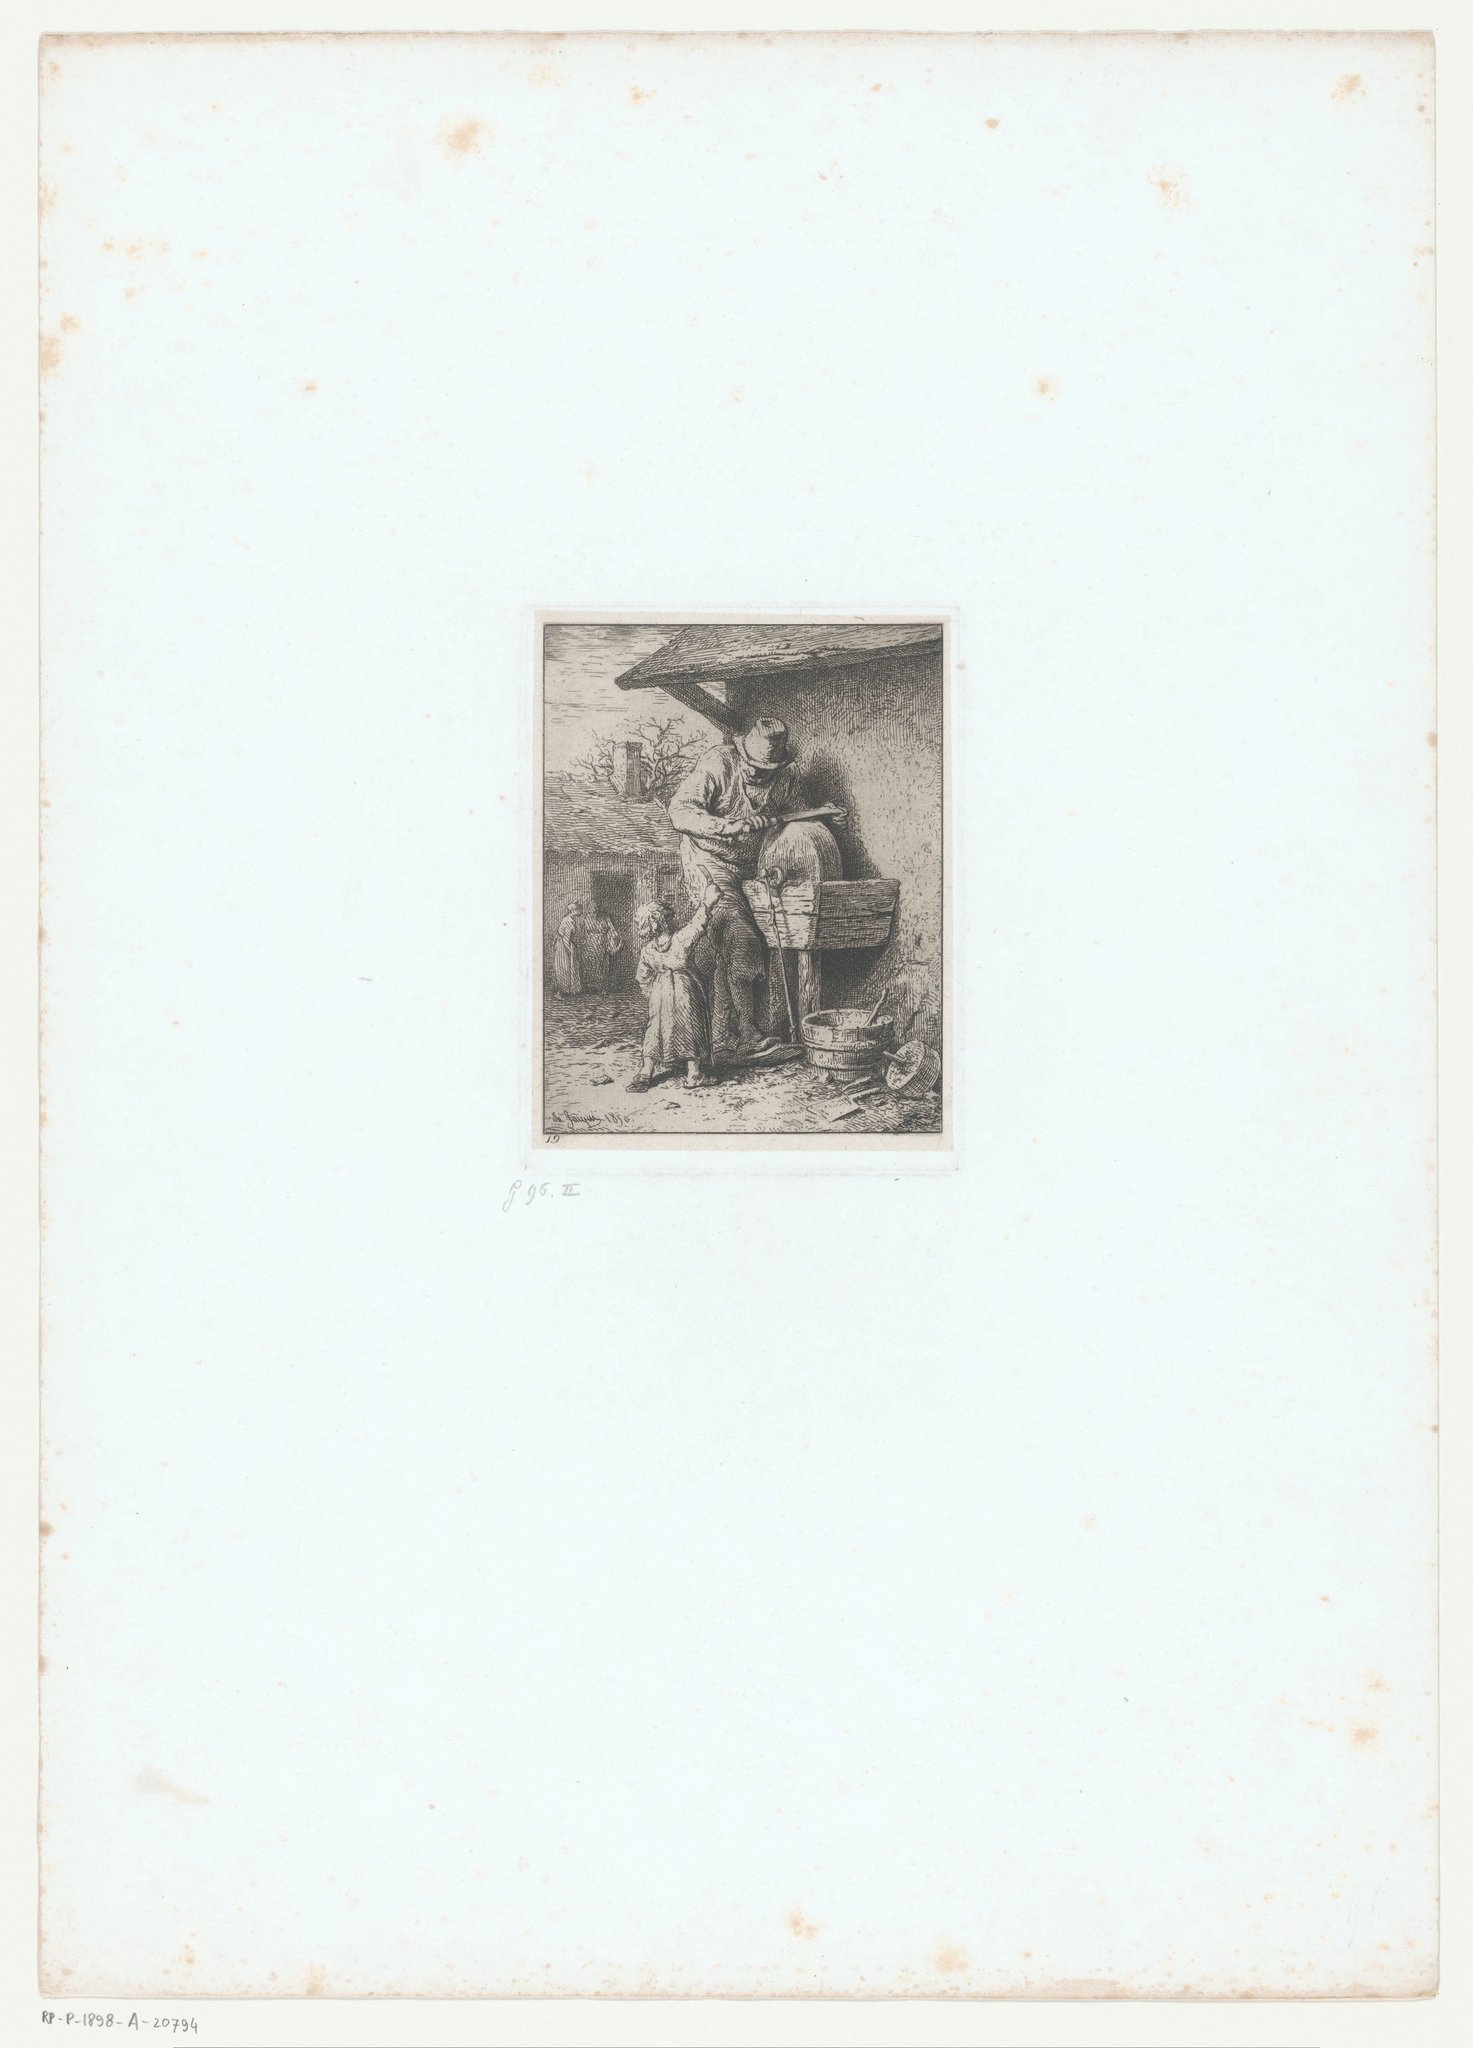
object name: print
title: 20 sujets composés et gravés à l'eau-forte par Ch. Jacque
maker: charles emile jacque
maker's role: draughtsman, painter, print maker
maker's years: 1813-1894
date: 1850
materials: paper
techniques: drypoint, etching, roulette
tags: sharpening, grinding (industrial processes), street-trader, tools, aids, implements ~ crafts and industries: knife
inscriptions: collector's mark: Lugt 964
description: Maakt deel uit van een twintigdelige serie met verschillende onderwerpen door Jacque.